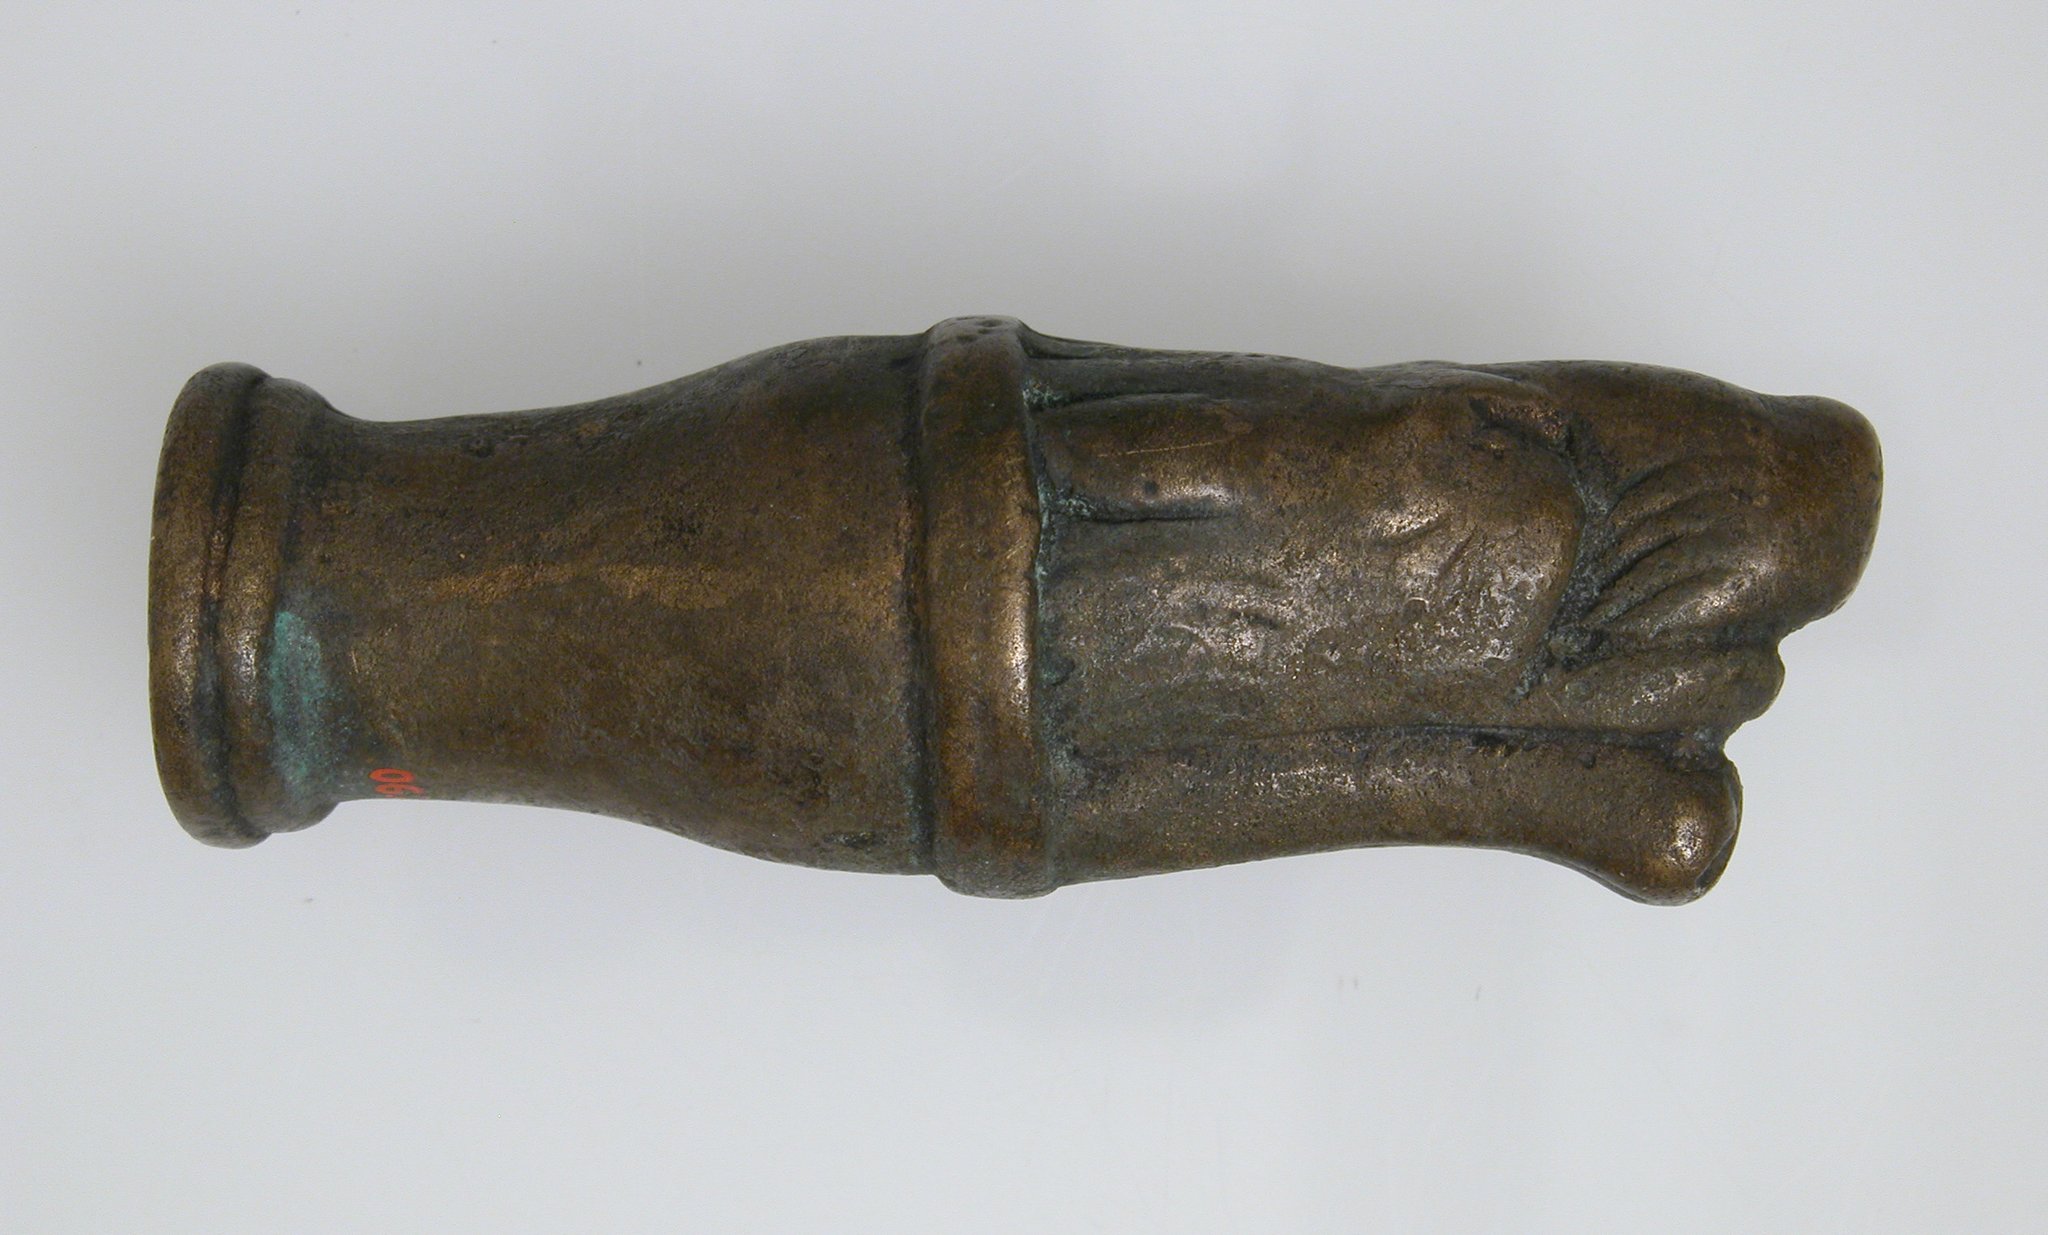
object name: key handle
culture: roman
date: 1-700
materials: copper alloy